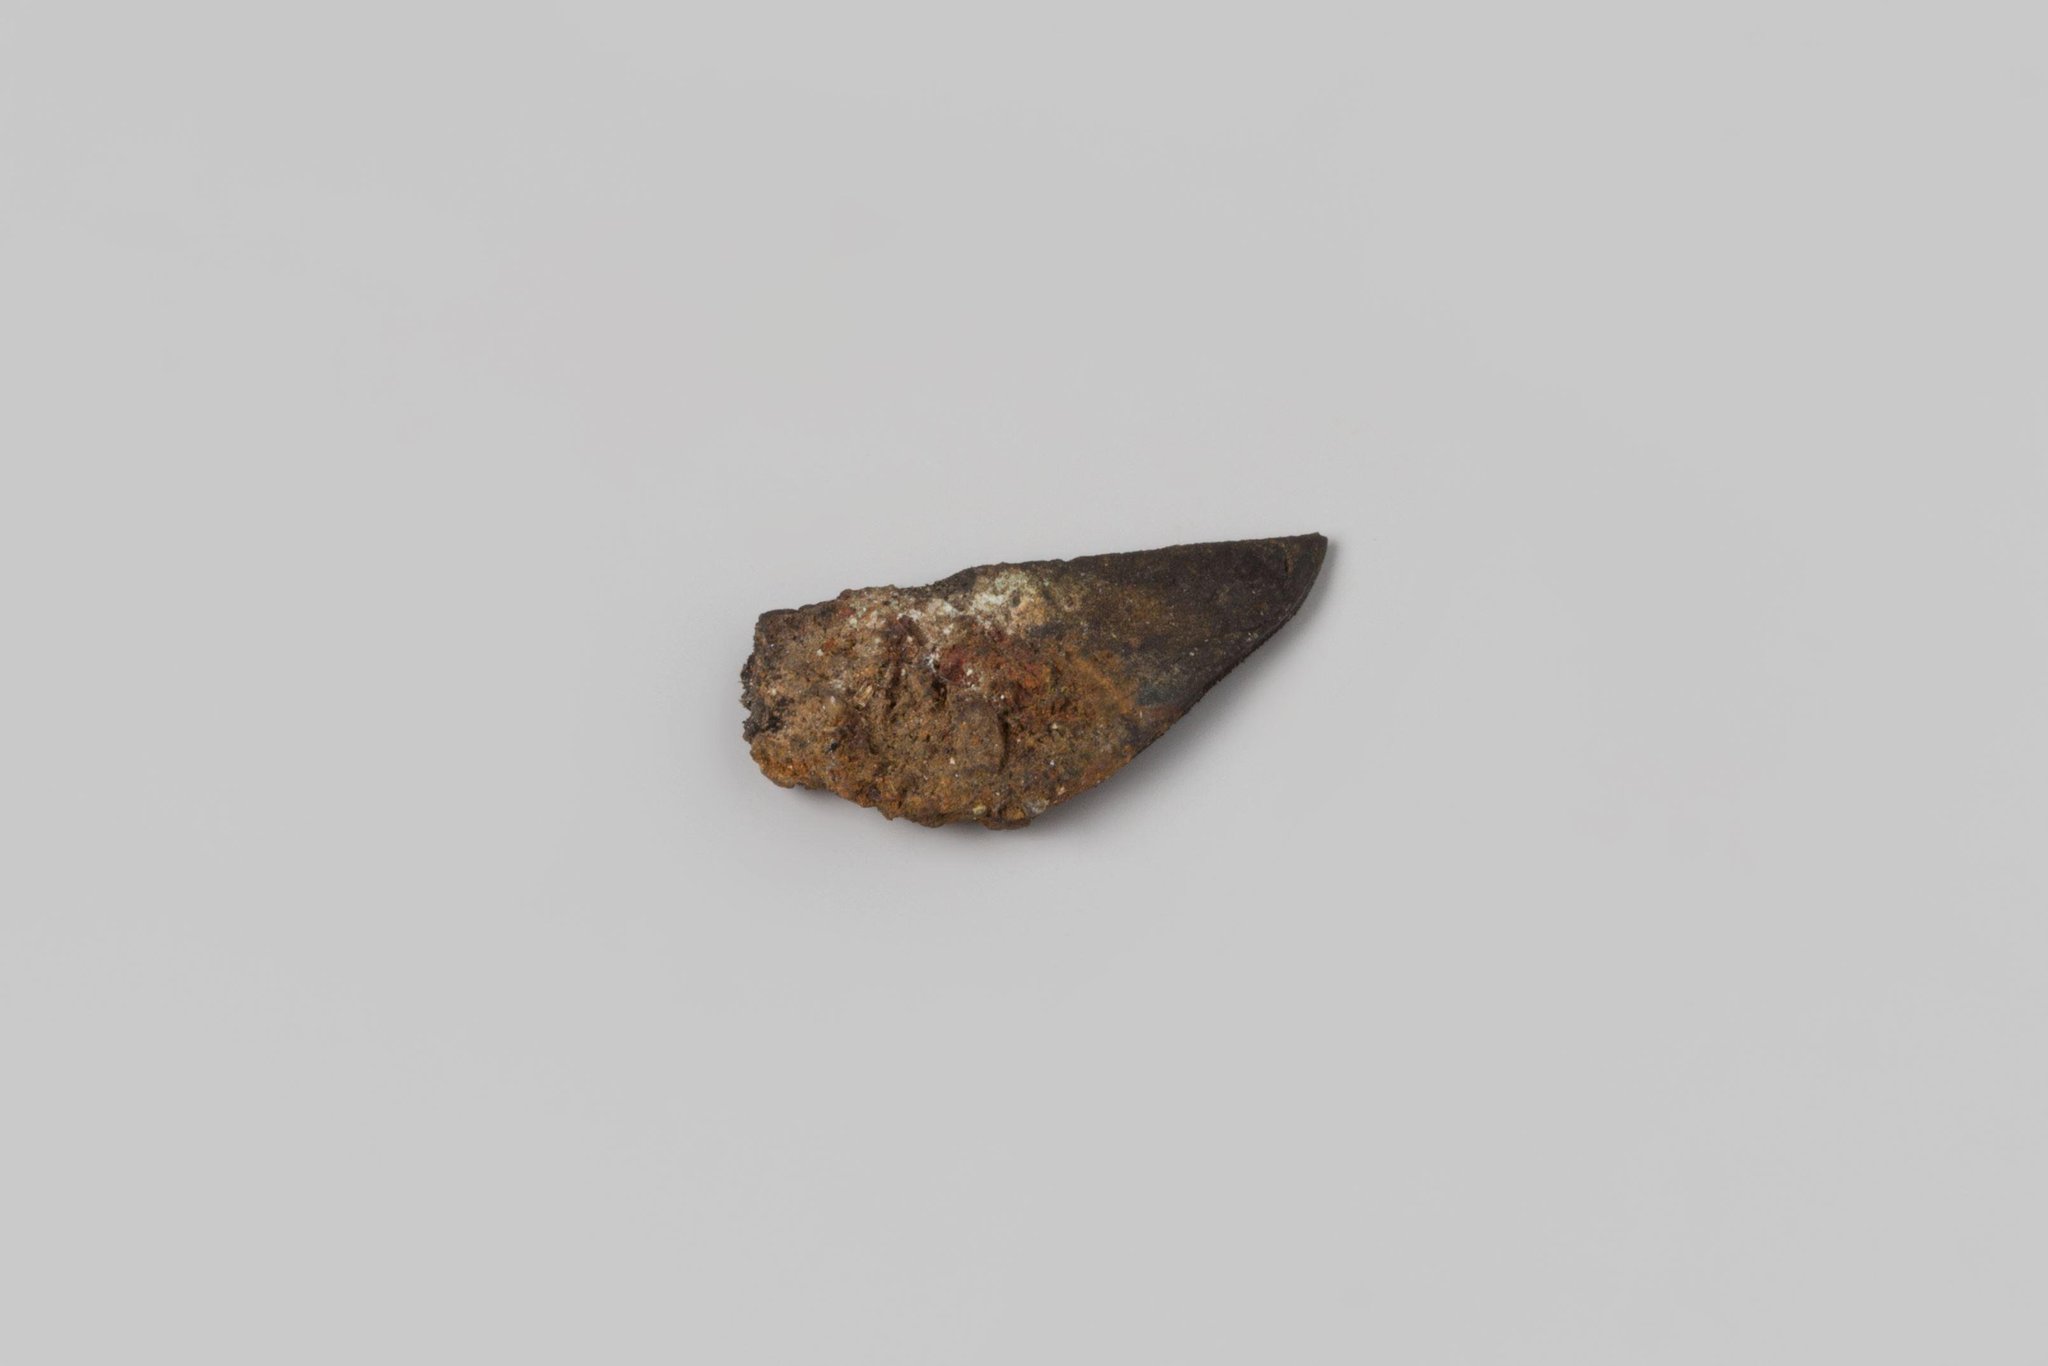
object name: scheepswrakvondst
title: Fragment van zilver uit het wrak van de Oost-Indiëvaarder Hollandia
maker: Anonymous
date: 1700-1743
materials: silver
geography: netherlands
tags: verenigde oostindische compagnie, hollandia (schip), annet